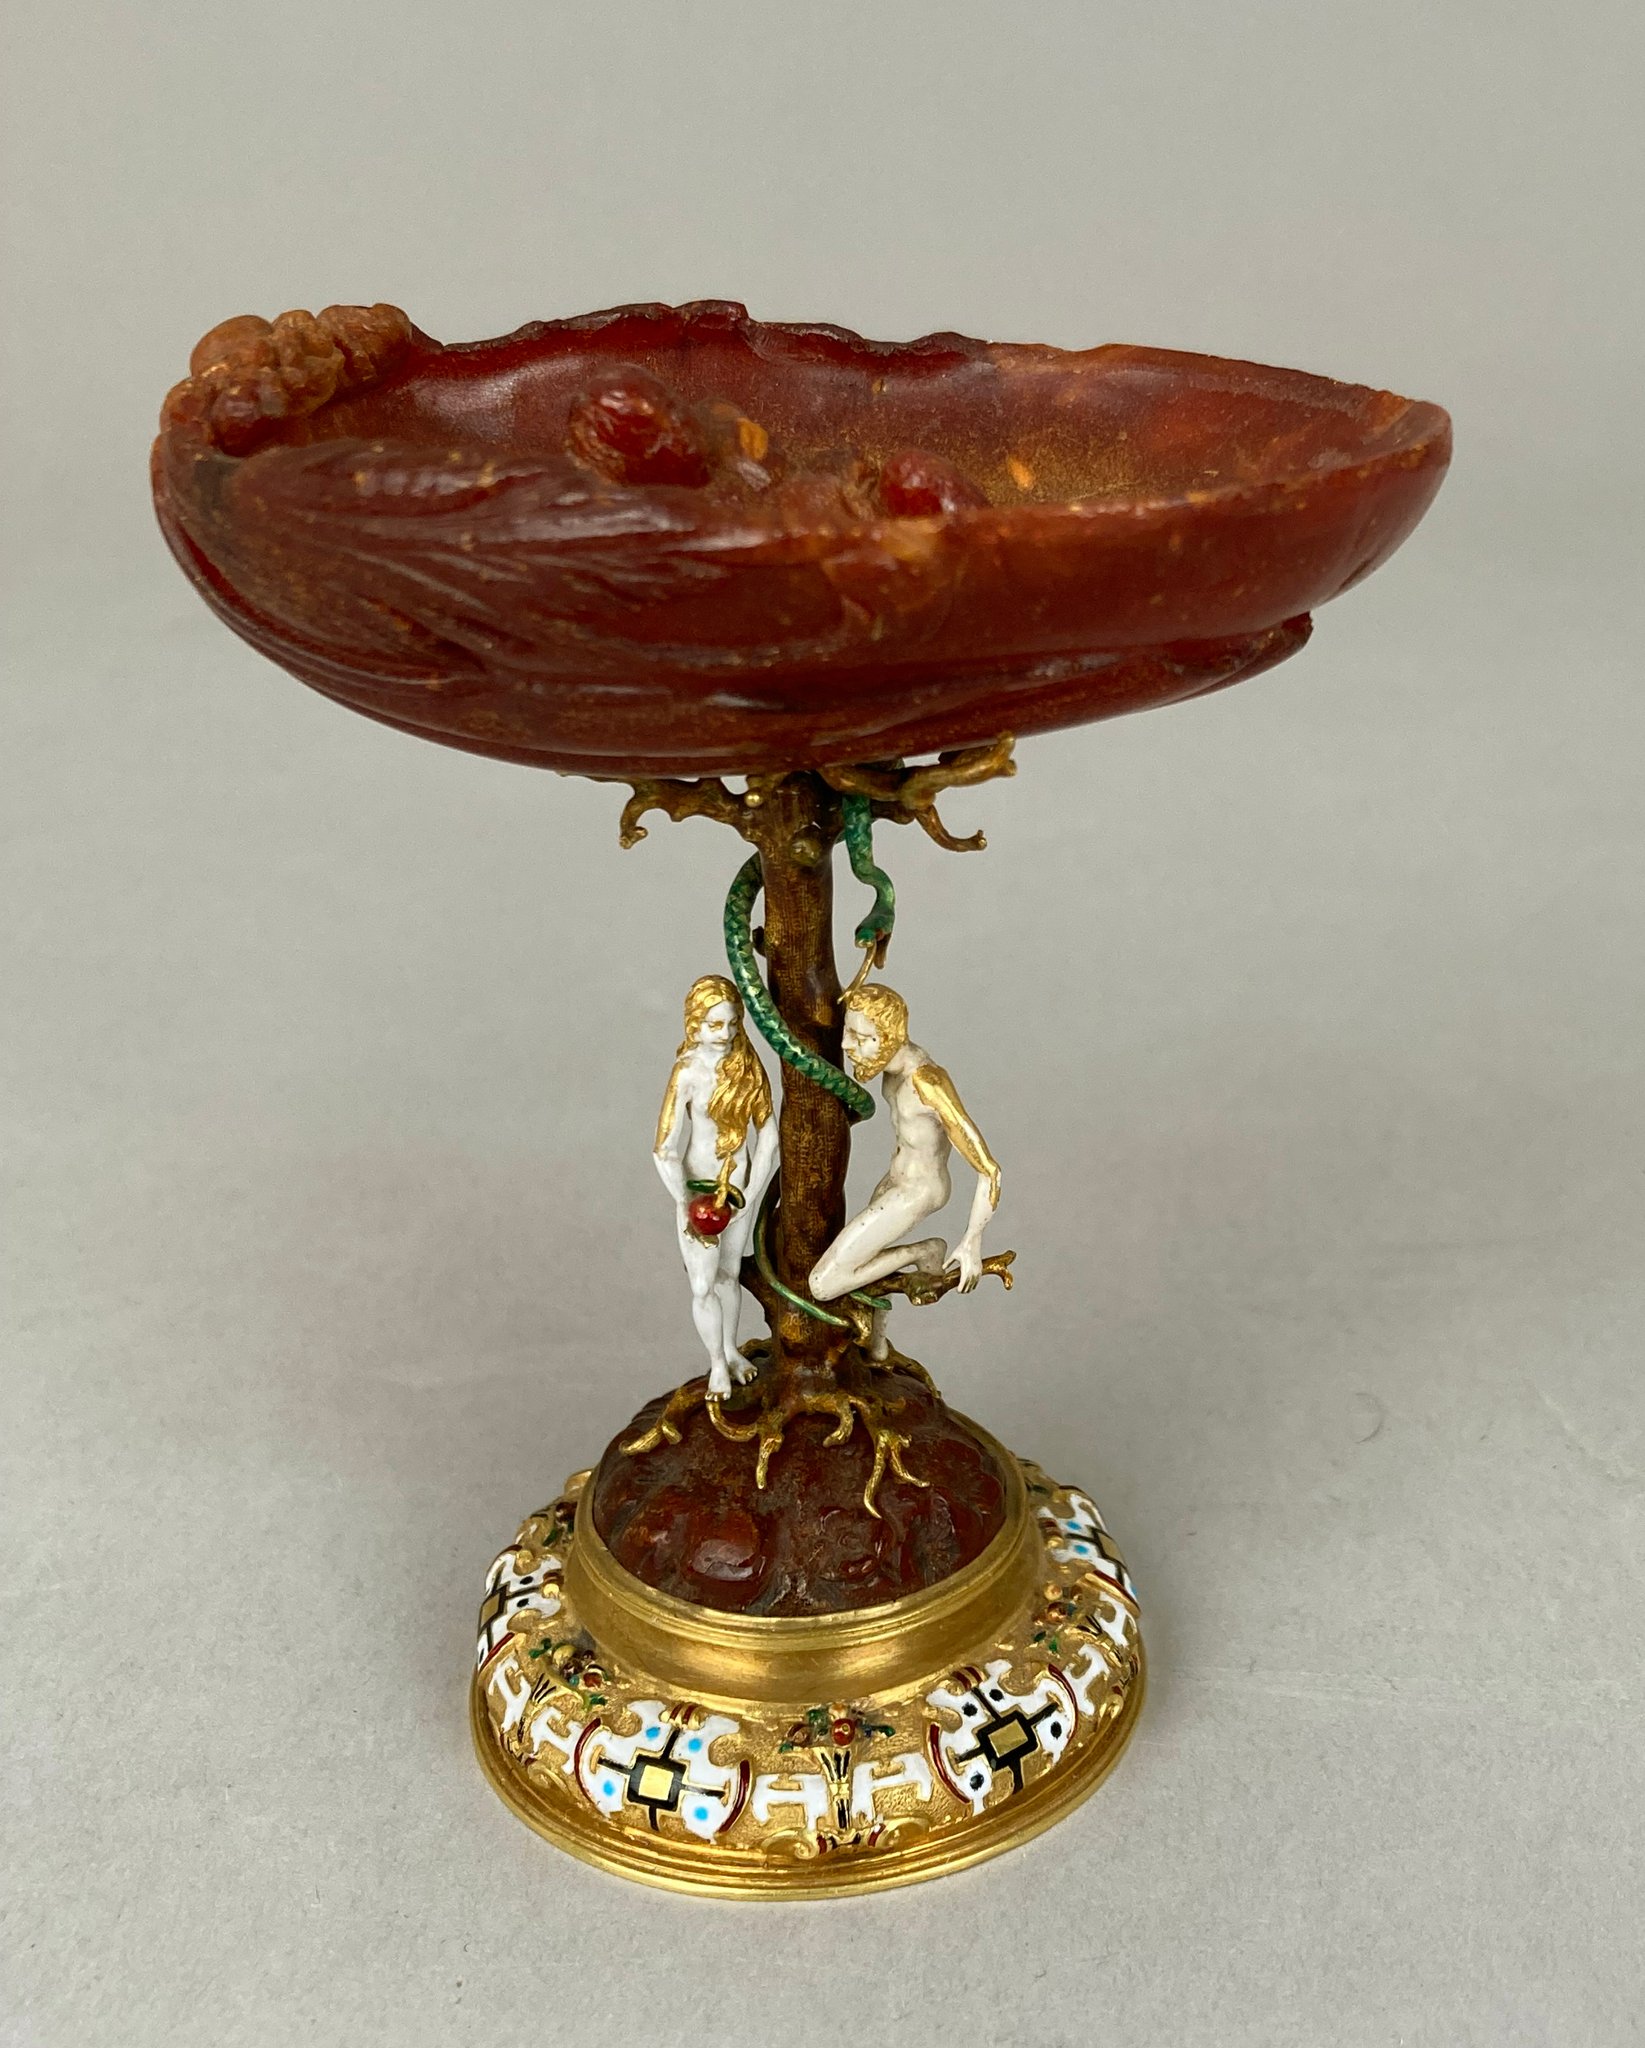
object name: cup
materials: amber, enamel, gold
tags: male nudes,female nudes,adam,eve